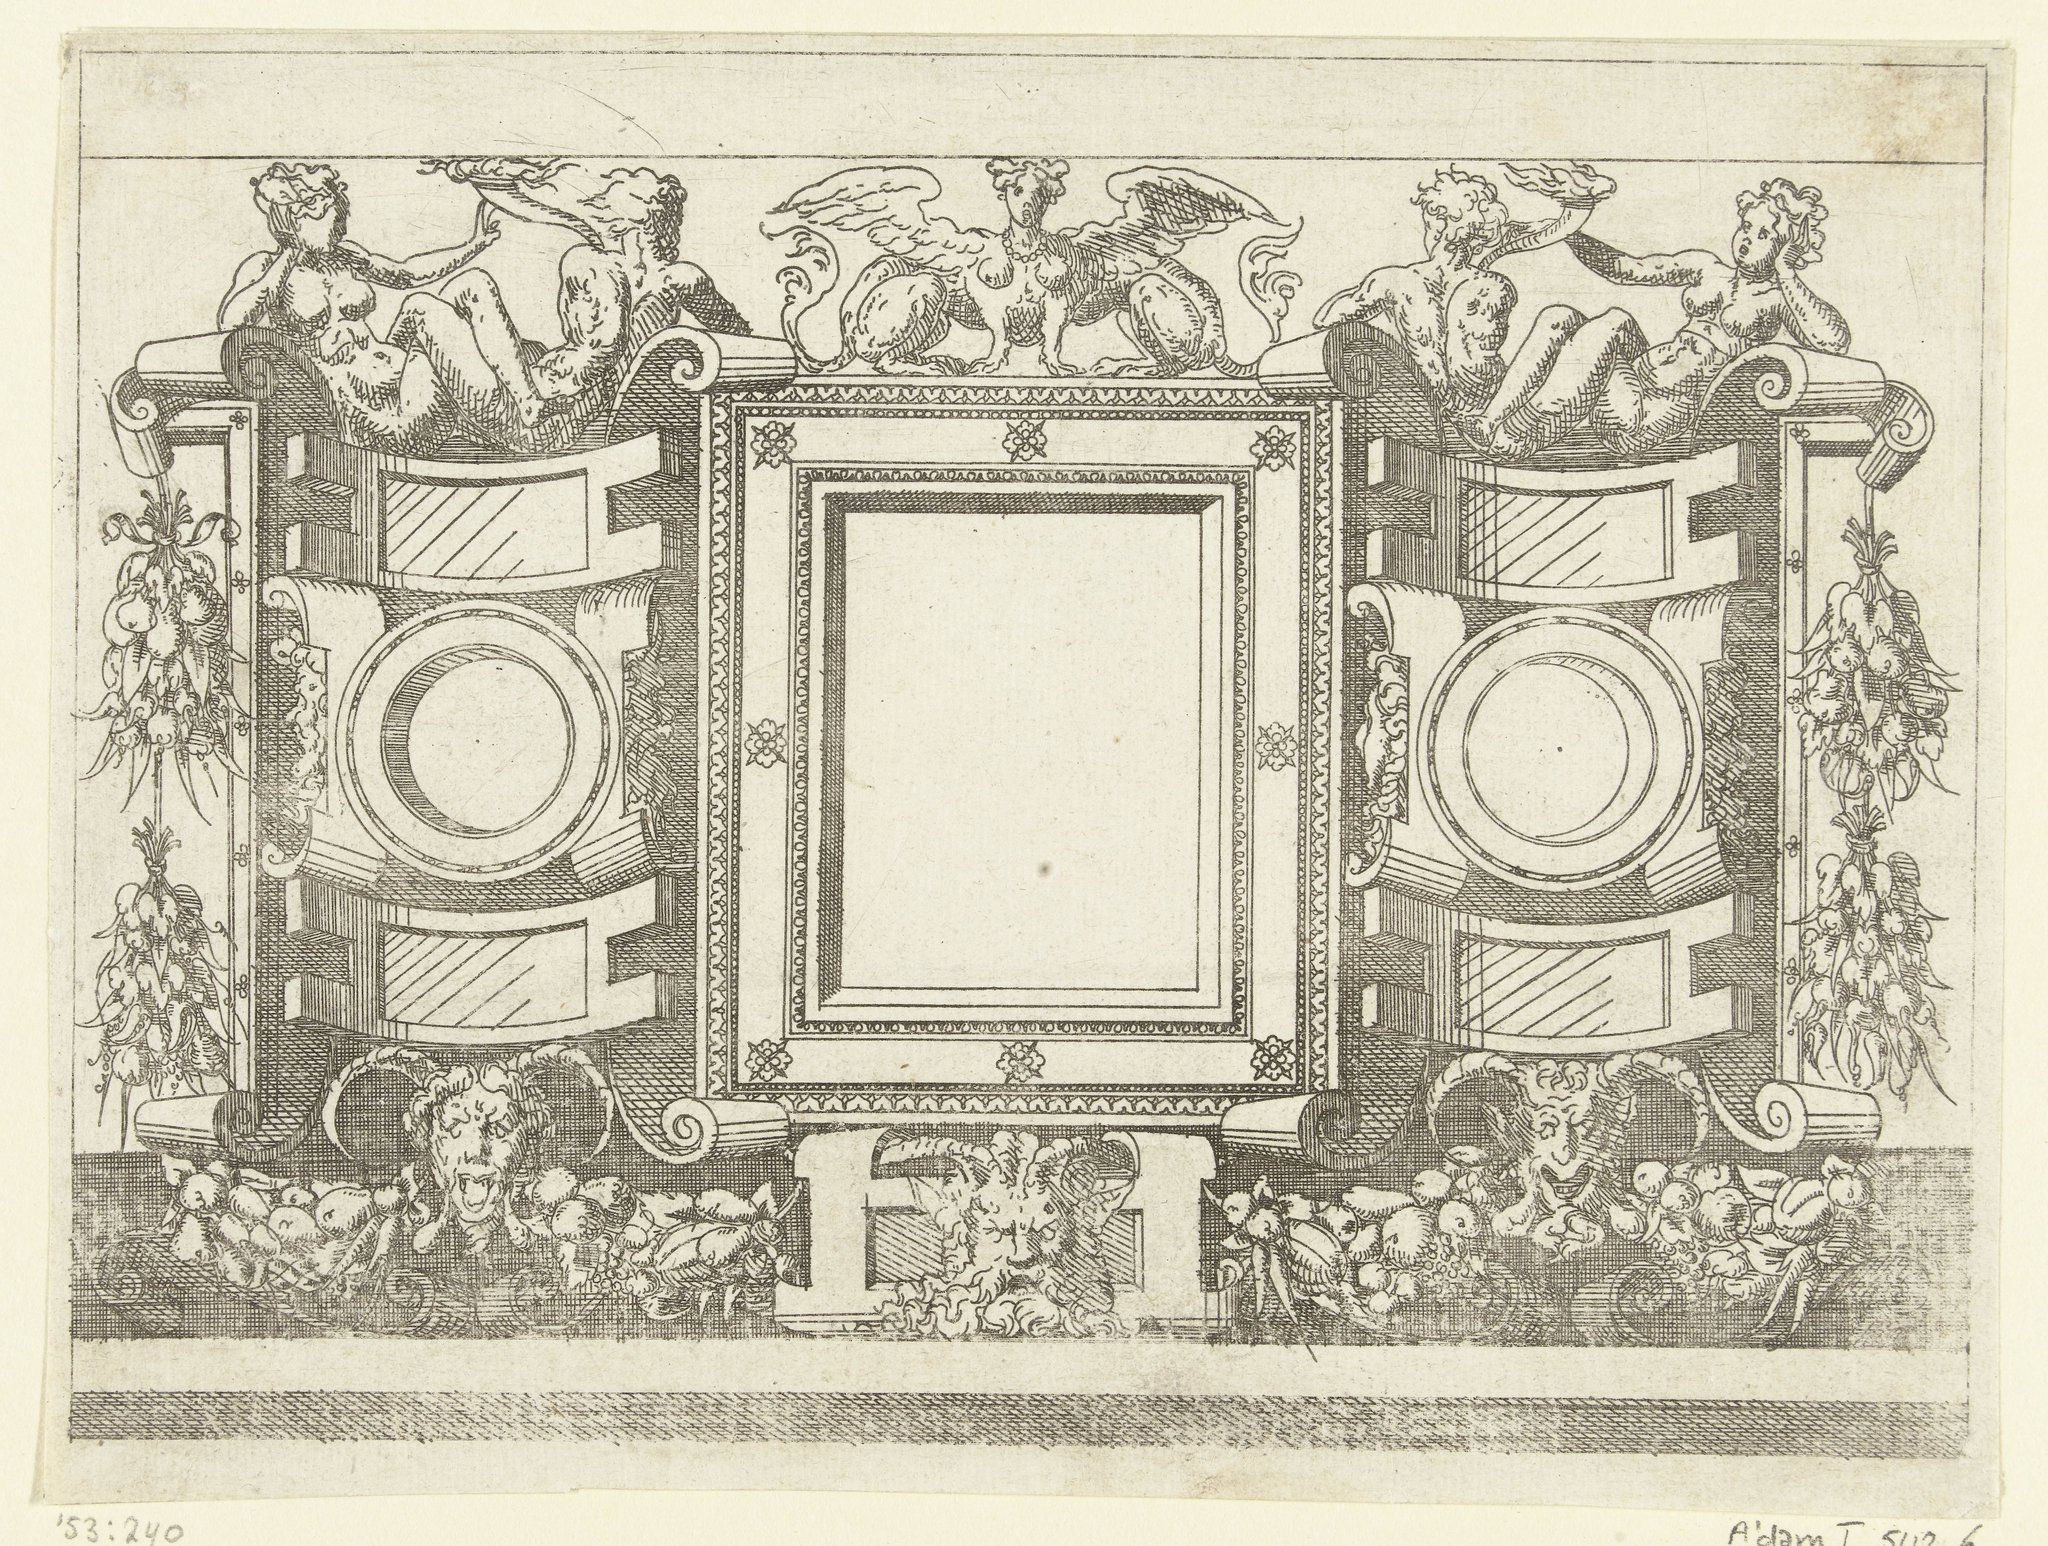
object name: ornament print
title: Kleine cartouche naar voorbeeld te Fontainebleau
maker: Anonymous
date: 1520-1584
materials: paper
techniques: etching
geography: france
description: Boven en onder de ronde cartouches hangen smalle rechthoekige cartouches. Uit serie van 32 bladen. De cartouches zijn deels ontleend aan de prenten van Antonio Fantuzzi naar de decoratie van de Galerie van François 1er door Giovanni Battista Rosso. De serie staat ook bekend onder de titel Petits cartouches de Fontainebleau.